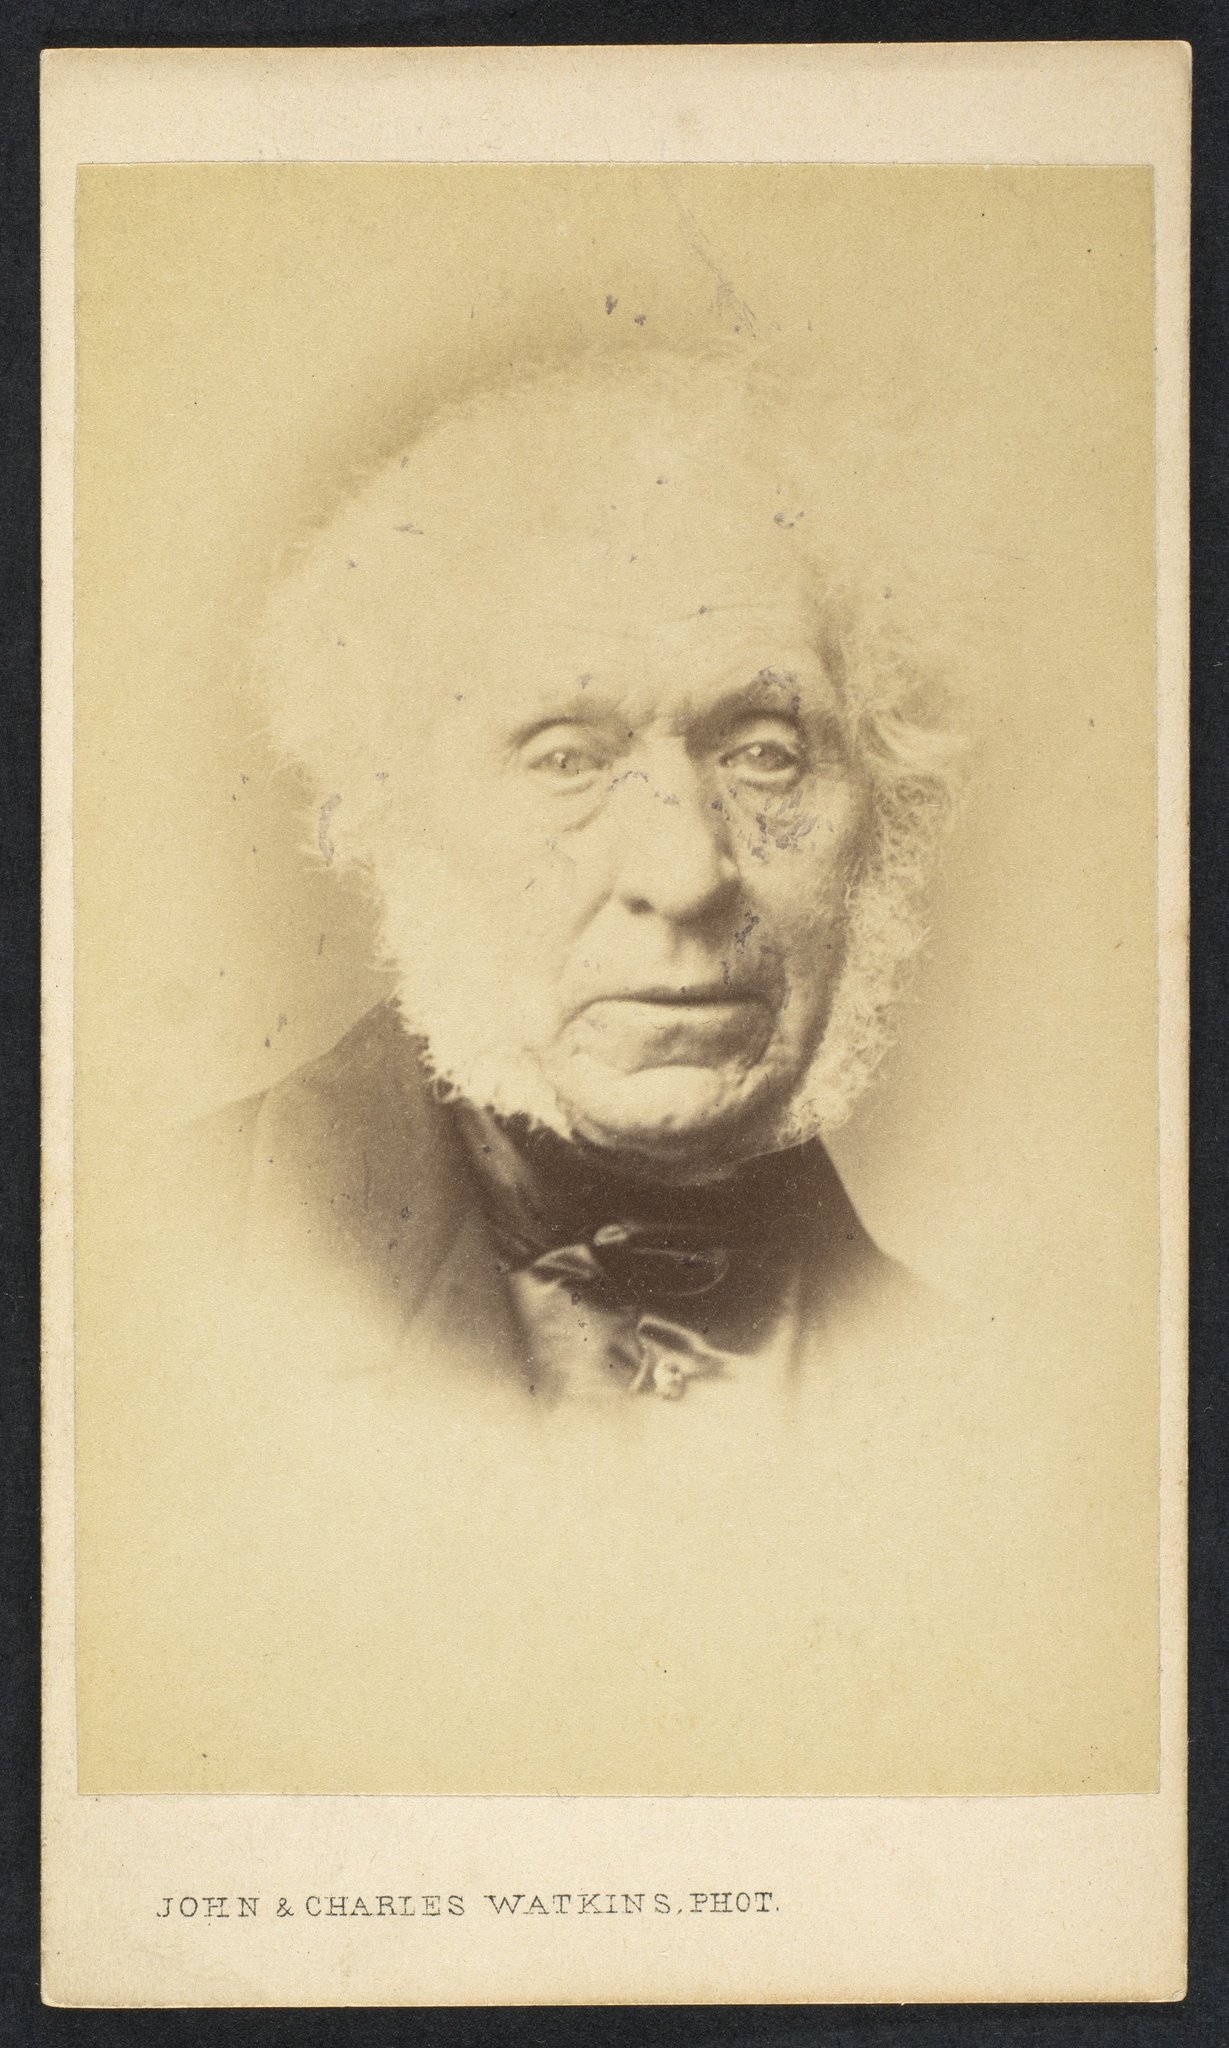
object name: carte de visite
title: [Sir David Brewster]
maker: john and charles watkins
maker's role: photography studio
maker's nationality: british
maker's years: 1840-1875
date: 1860-1869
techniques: albumen silver print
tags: men,portraits